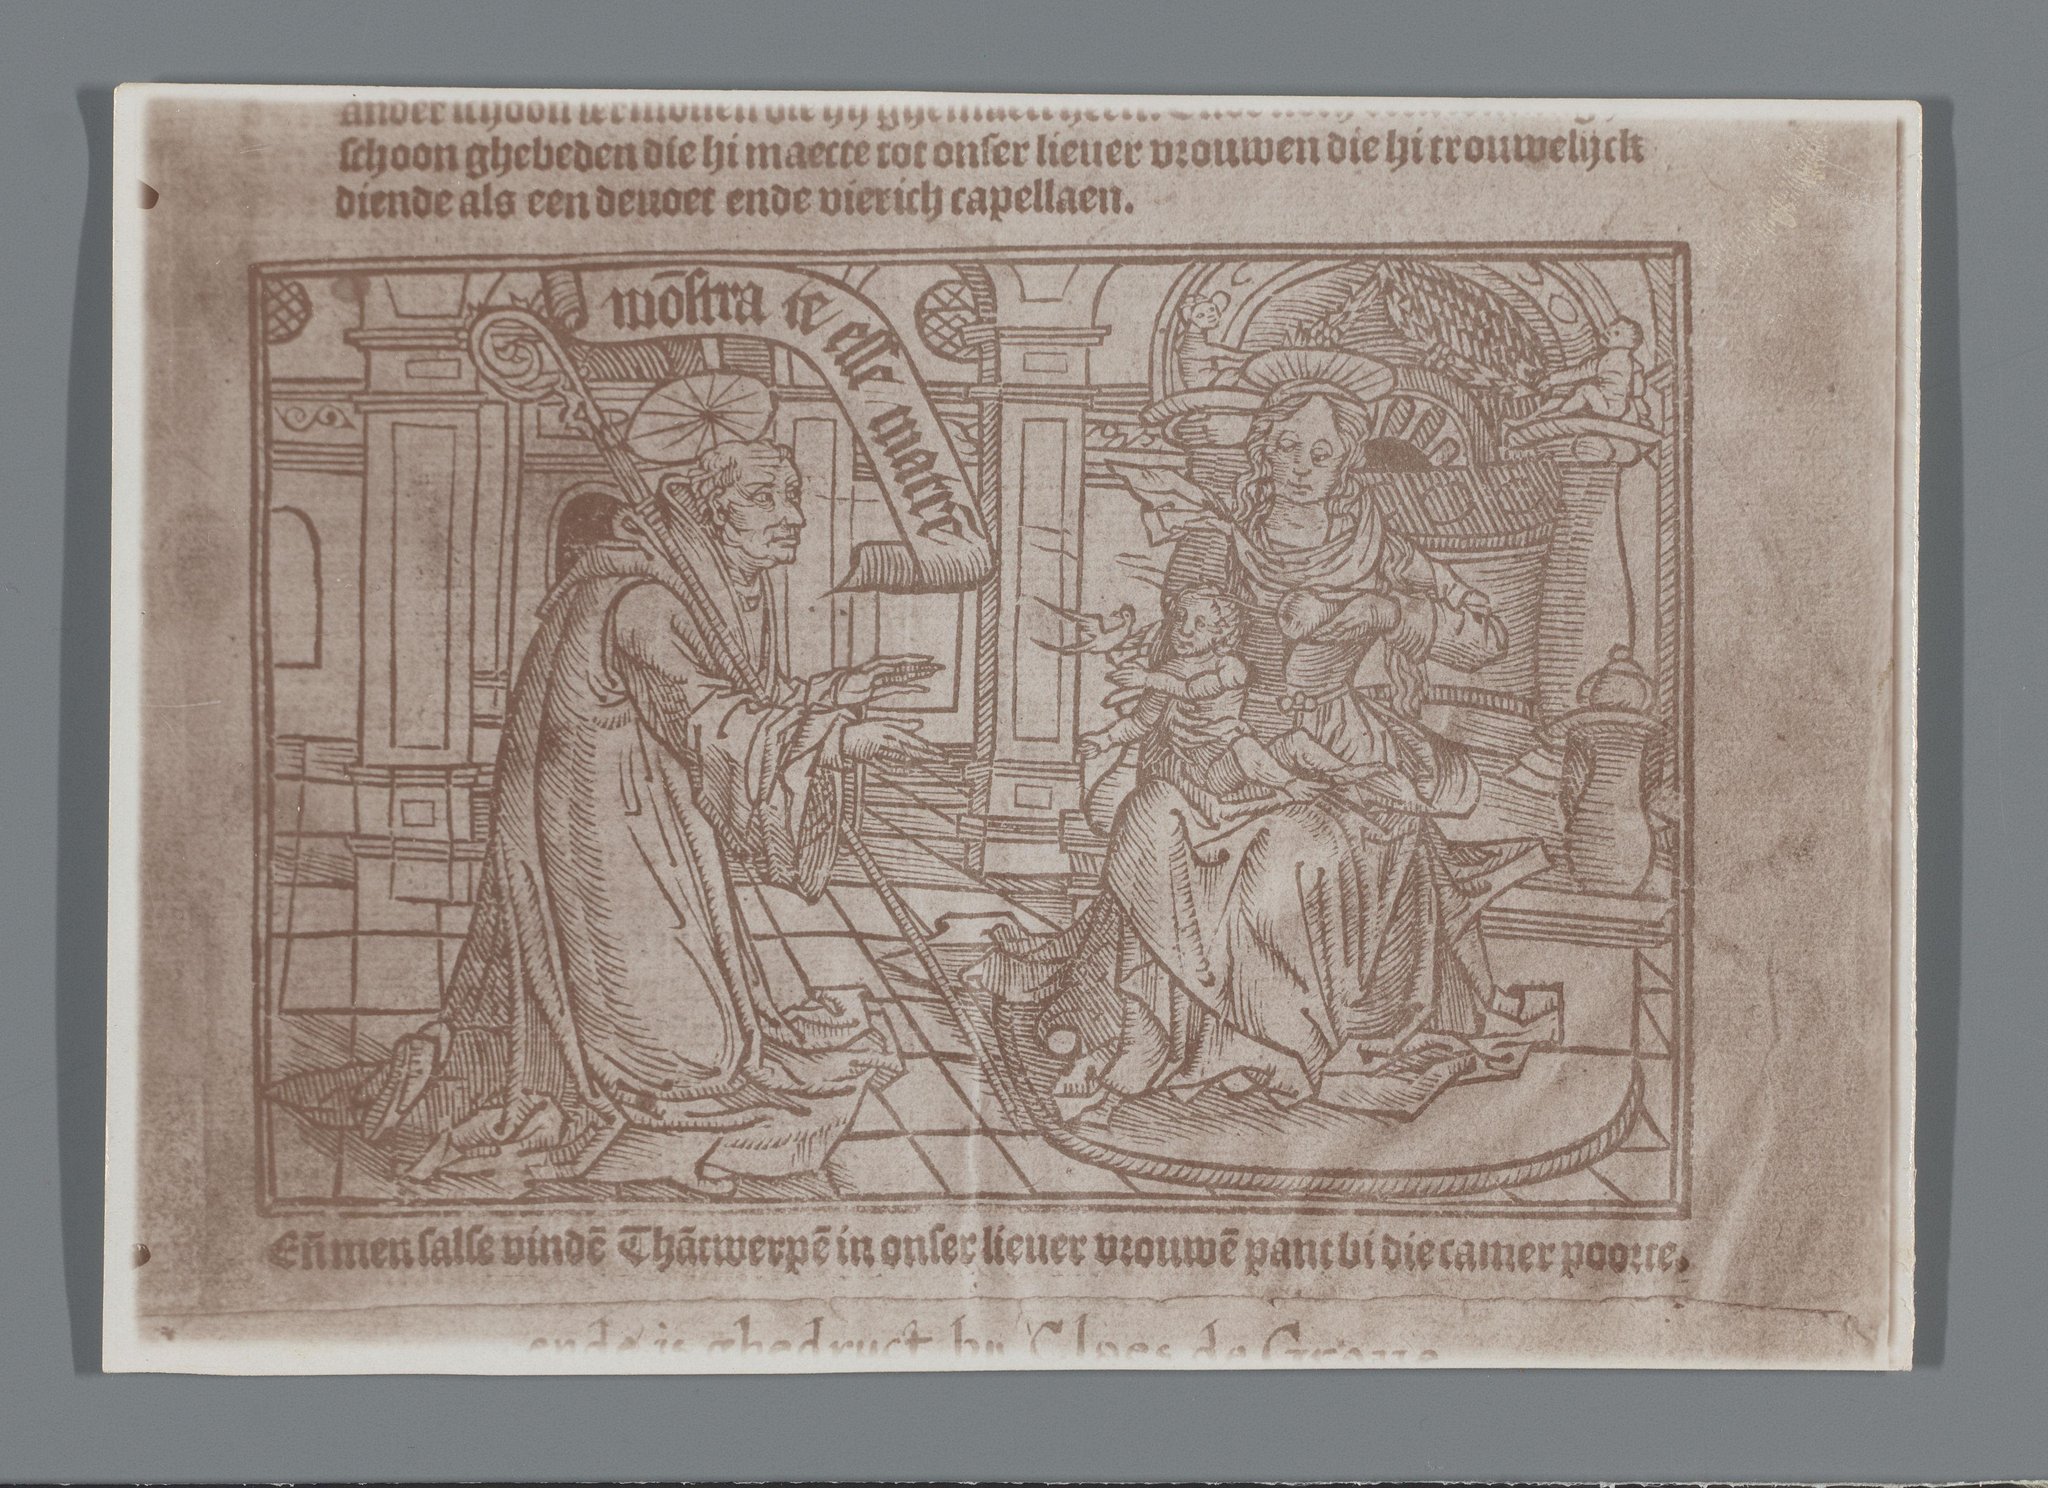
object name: reproduction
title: Fotoreproductie van een houtsnede van een heilige voor Maria met Christuskind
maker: Anonymous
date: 1890-1930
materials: paper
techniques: collodion silver print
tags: saints, 'ablactatio'; christ not drinking, mary's breast bare ~ madonna-representations